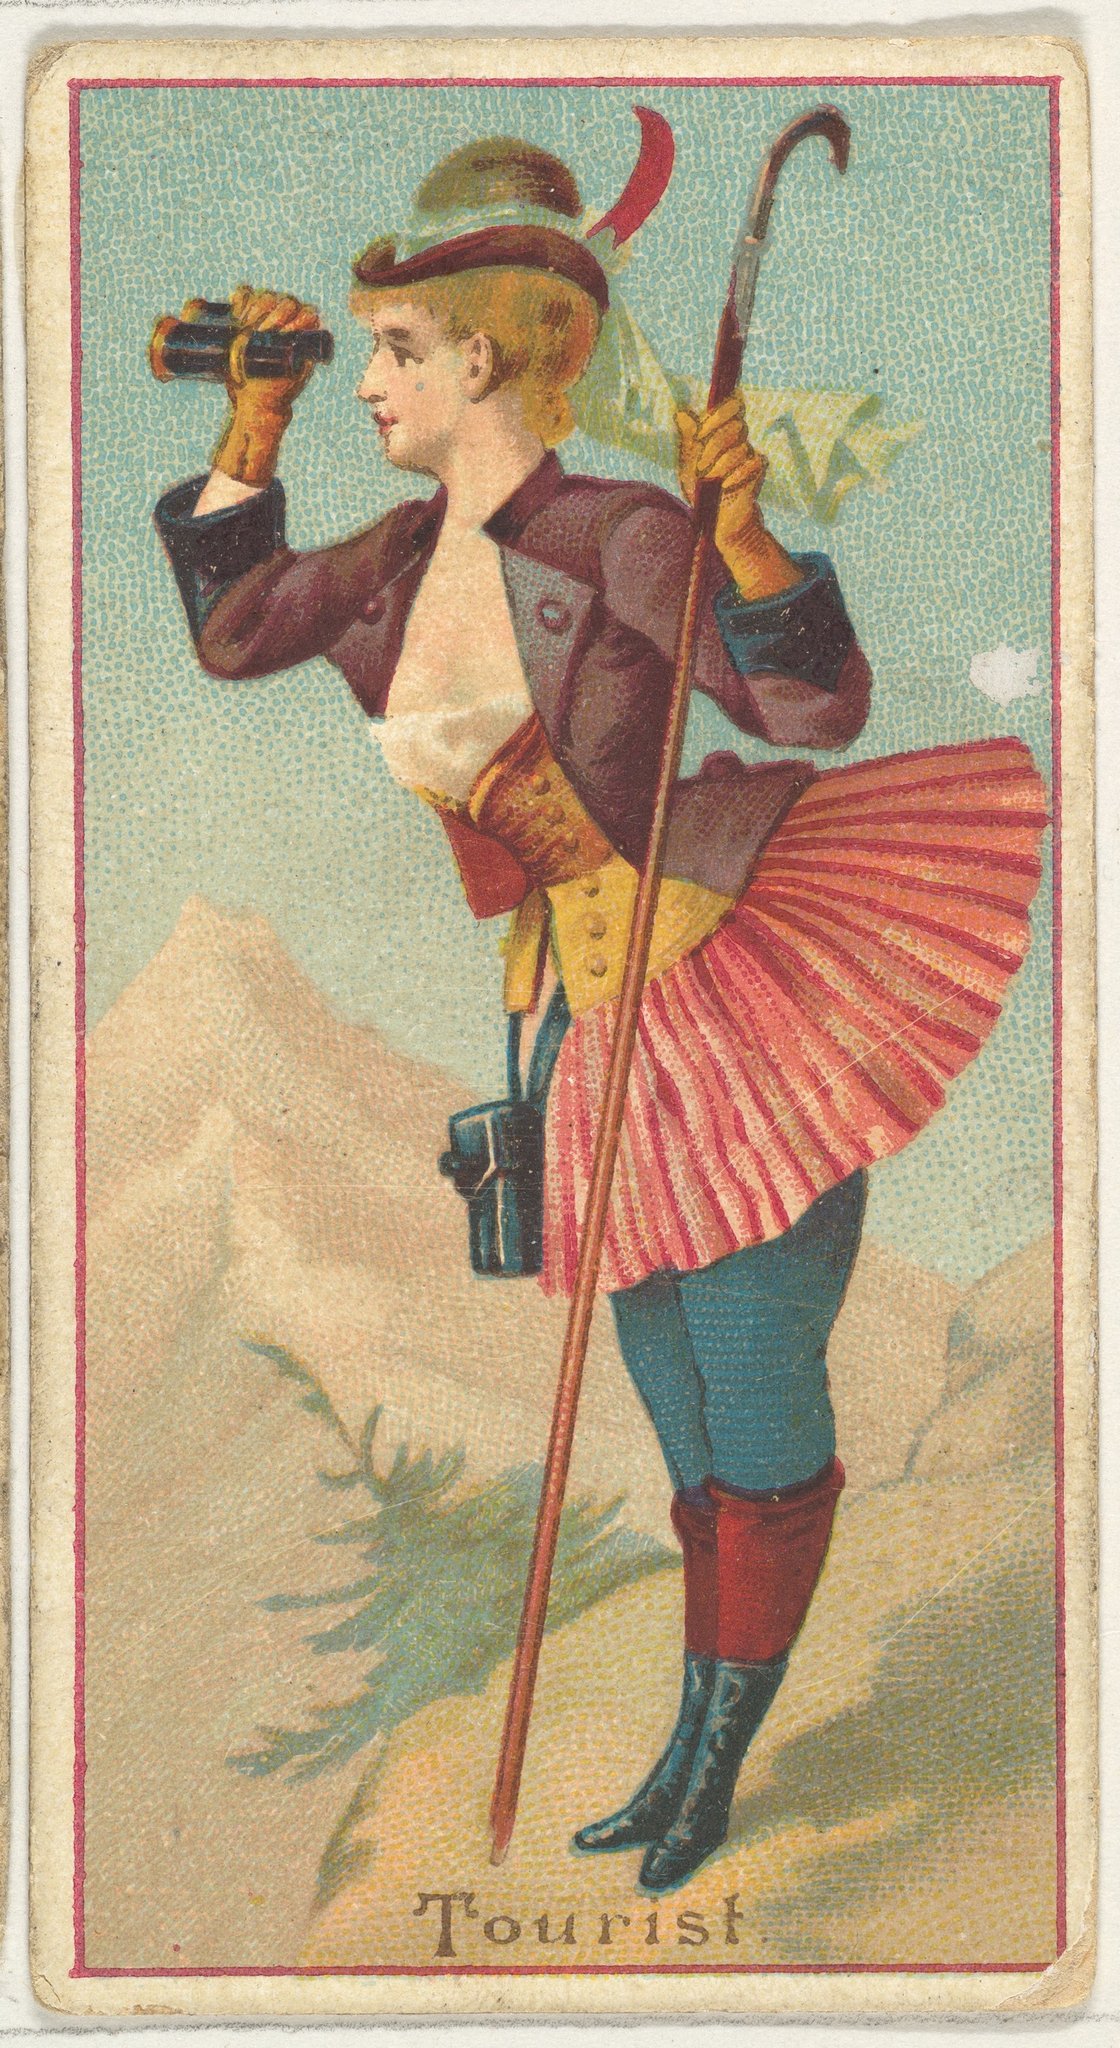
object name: print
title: Tourist, from the Occupations of Women series (N502) for Frishmuth's Tobacco Company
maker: frishmuth's tobacco company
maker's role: publisher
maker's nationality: american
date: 1889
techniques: color lithograph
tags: women,binoculars